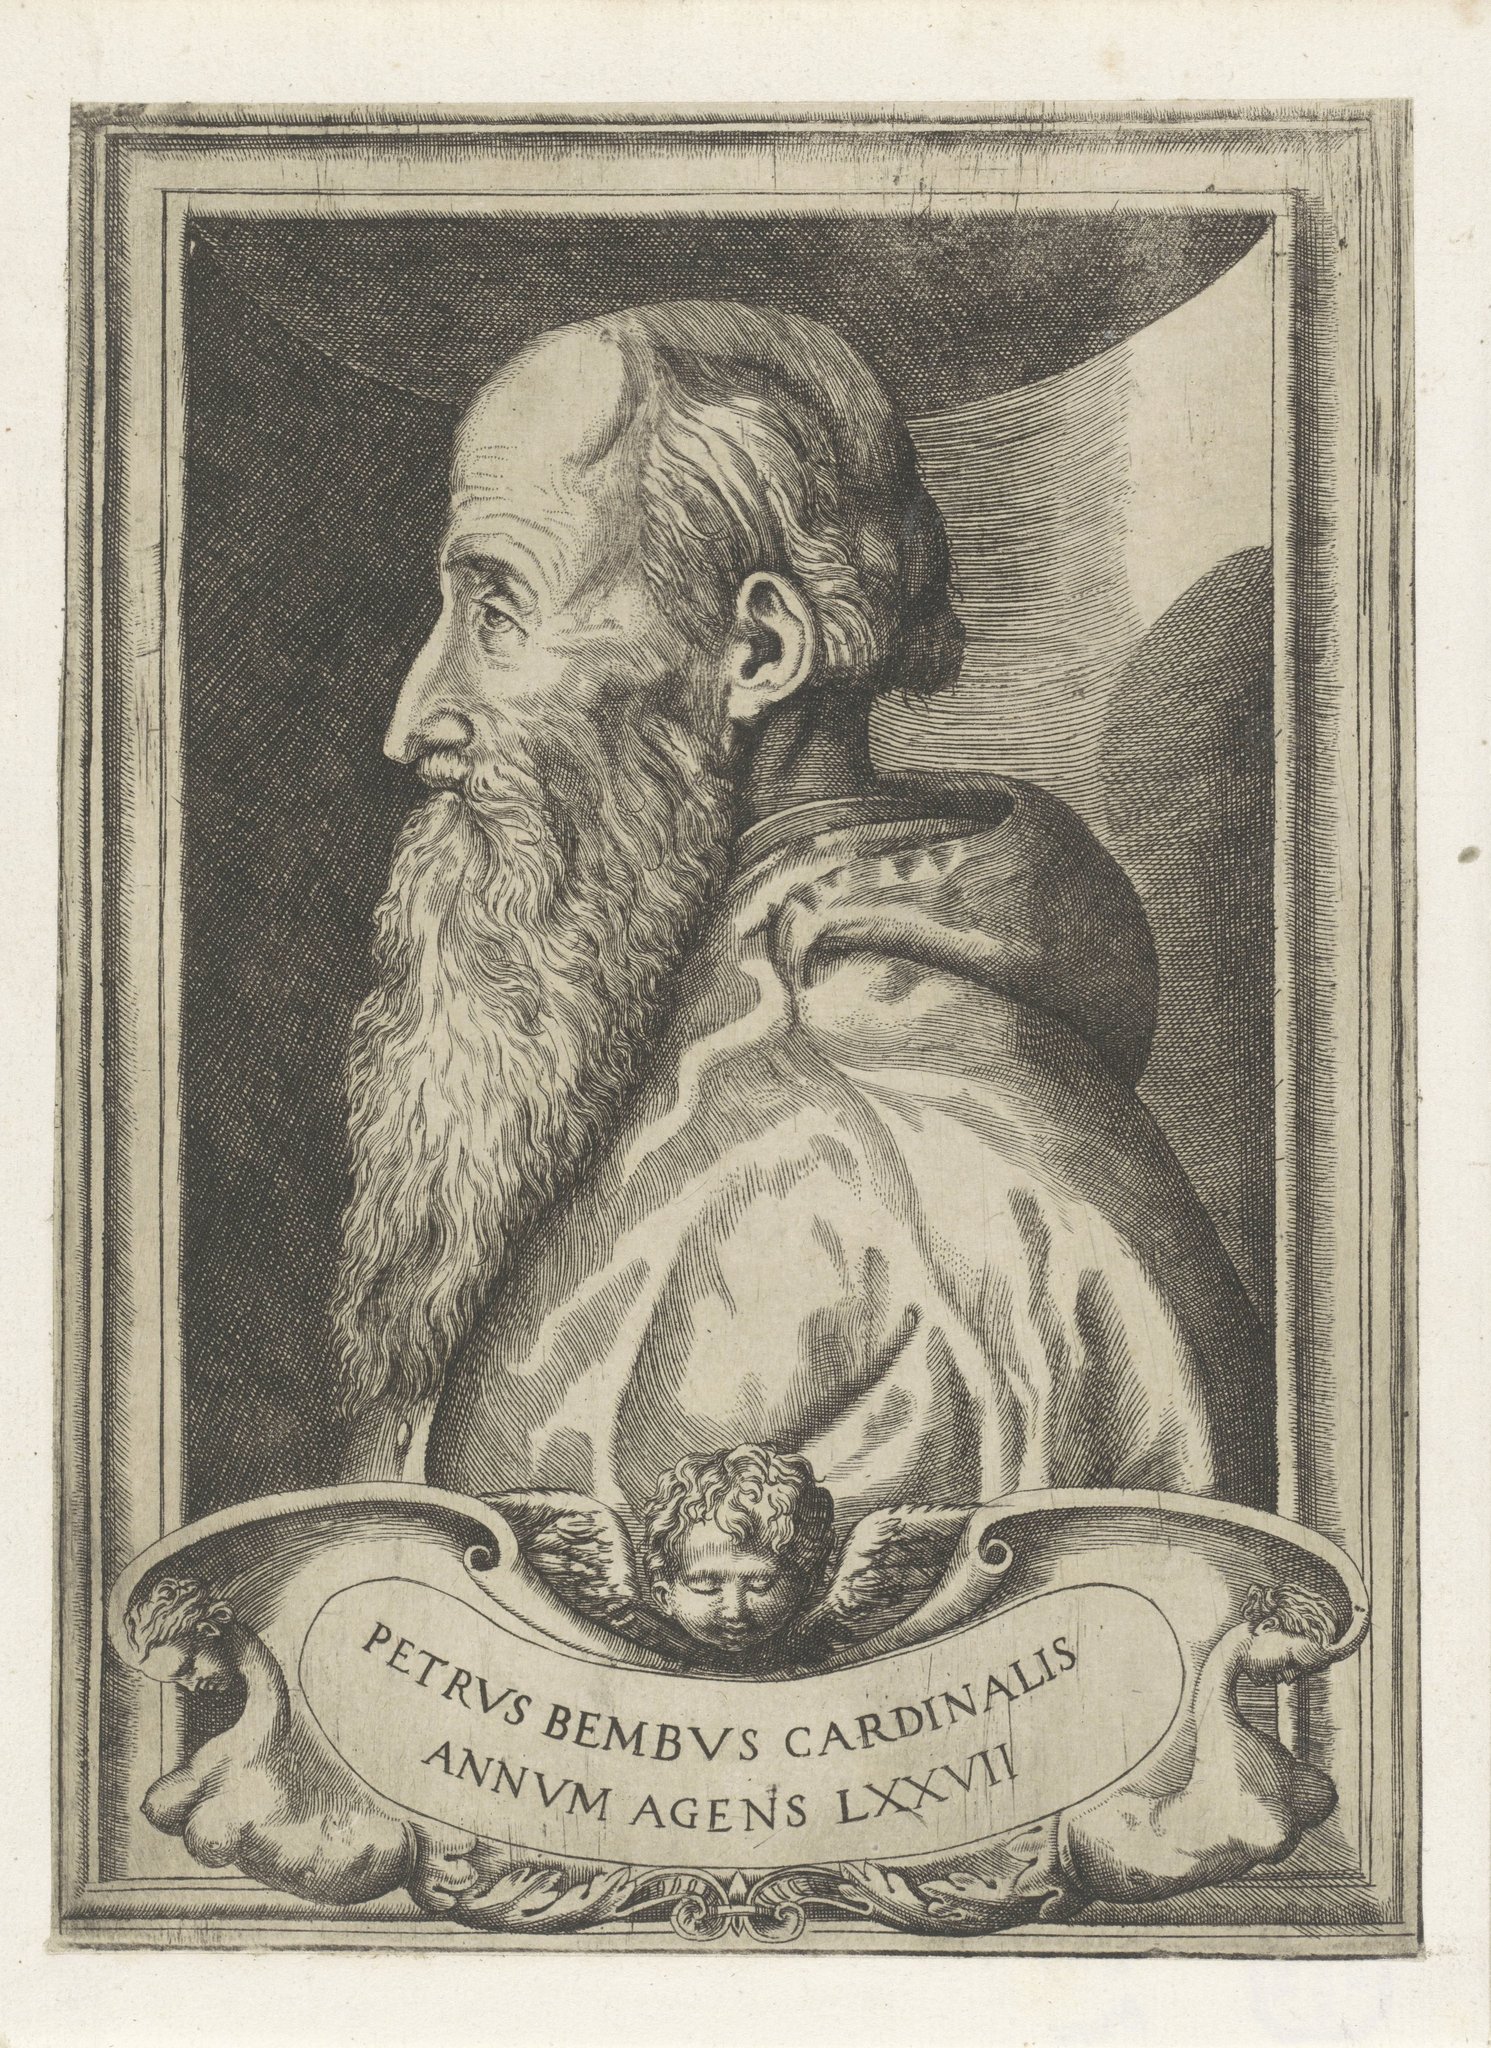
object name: print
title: Portret van kardinaal Pietro Bembo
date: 1501-1580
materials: paper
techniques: engraving, etching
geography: venice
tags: venice, cardinal, historical persons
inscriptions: collector's mark: ‘Hinloopen’, collector's mark: Lugt 10